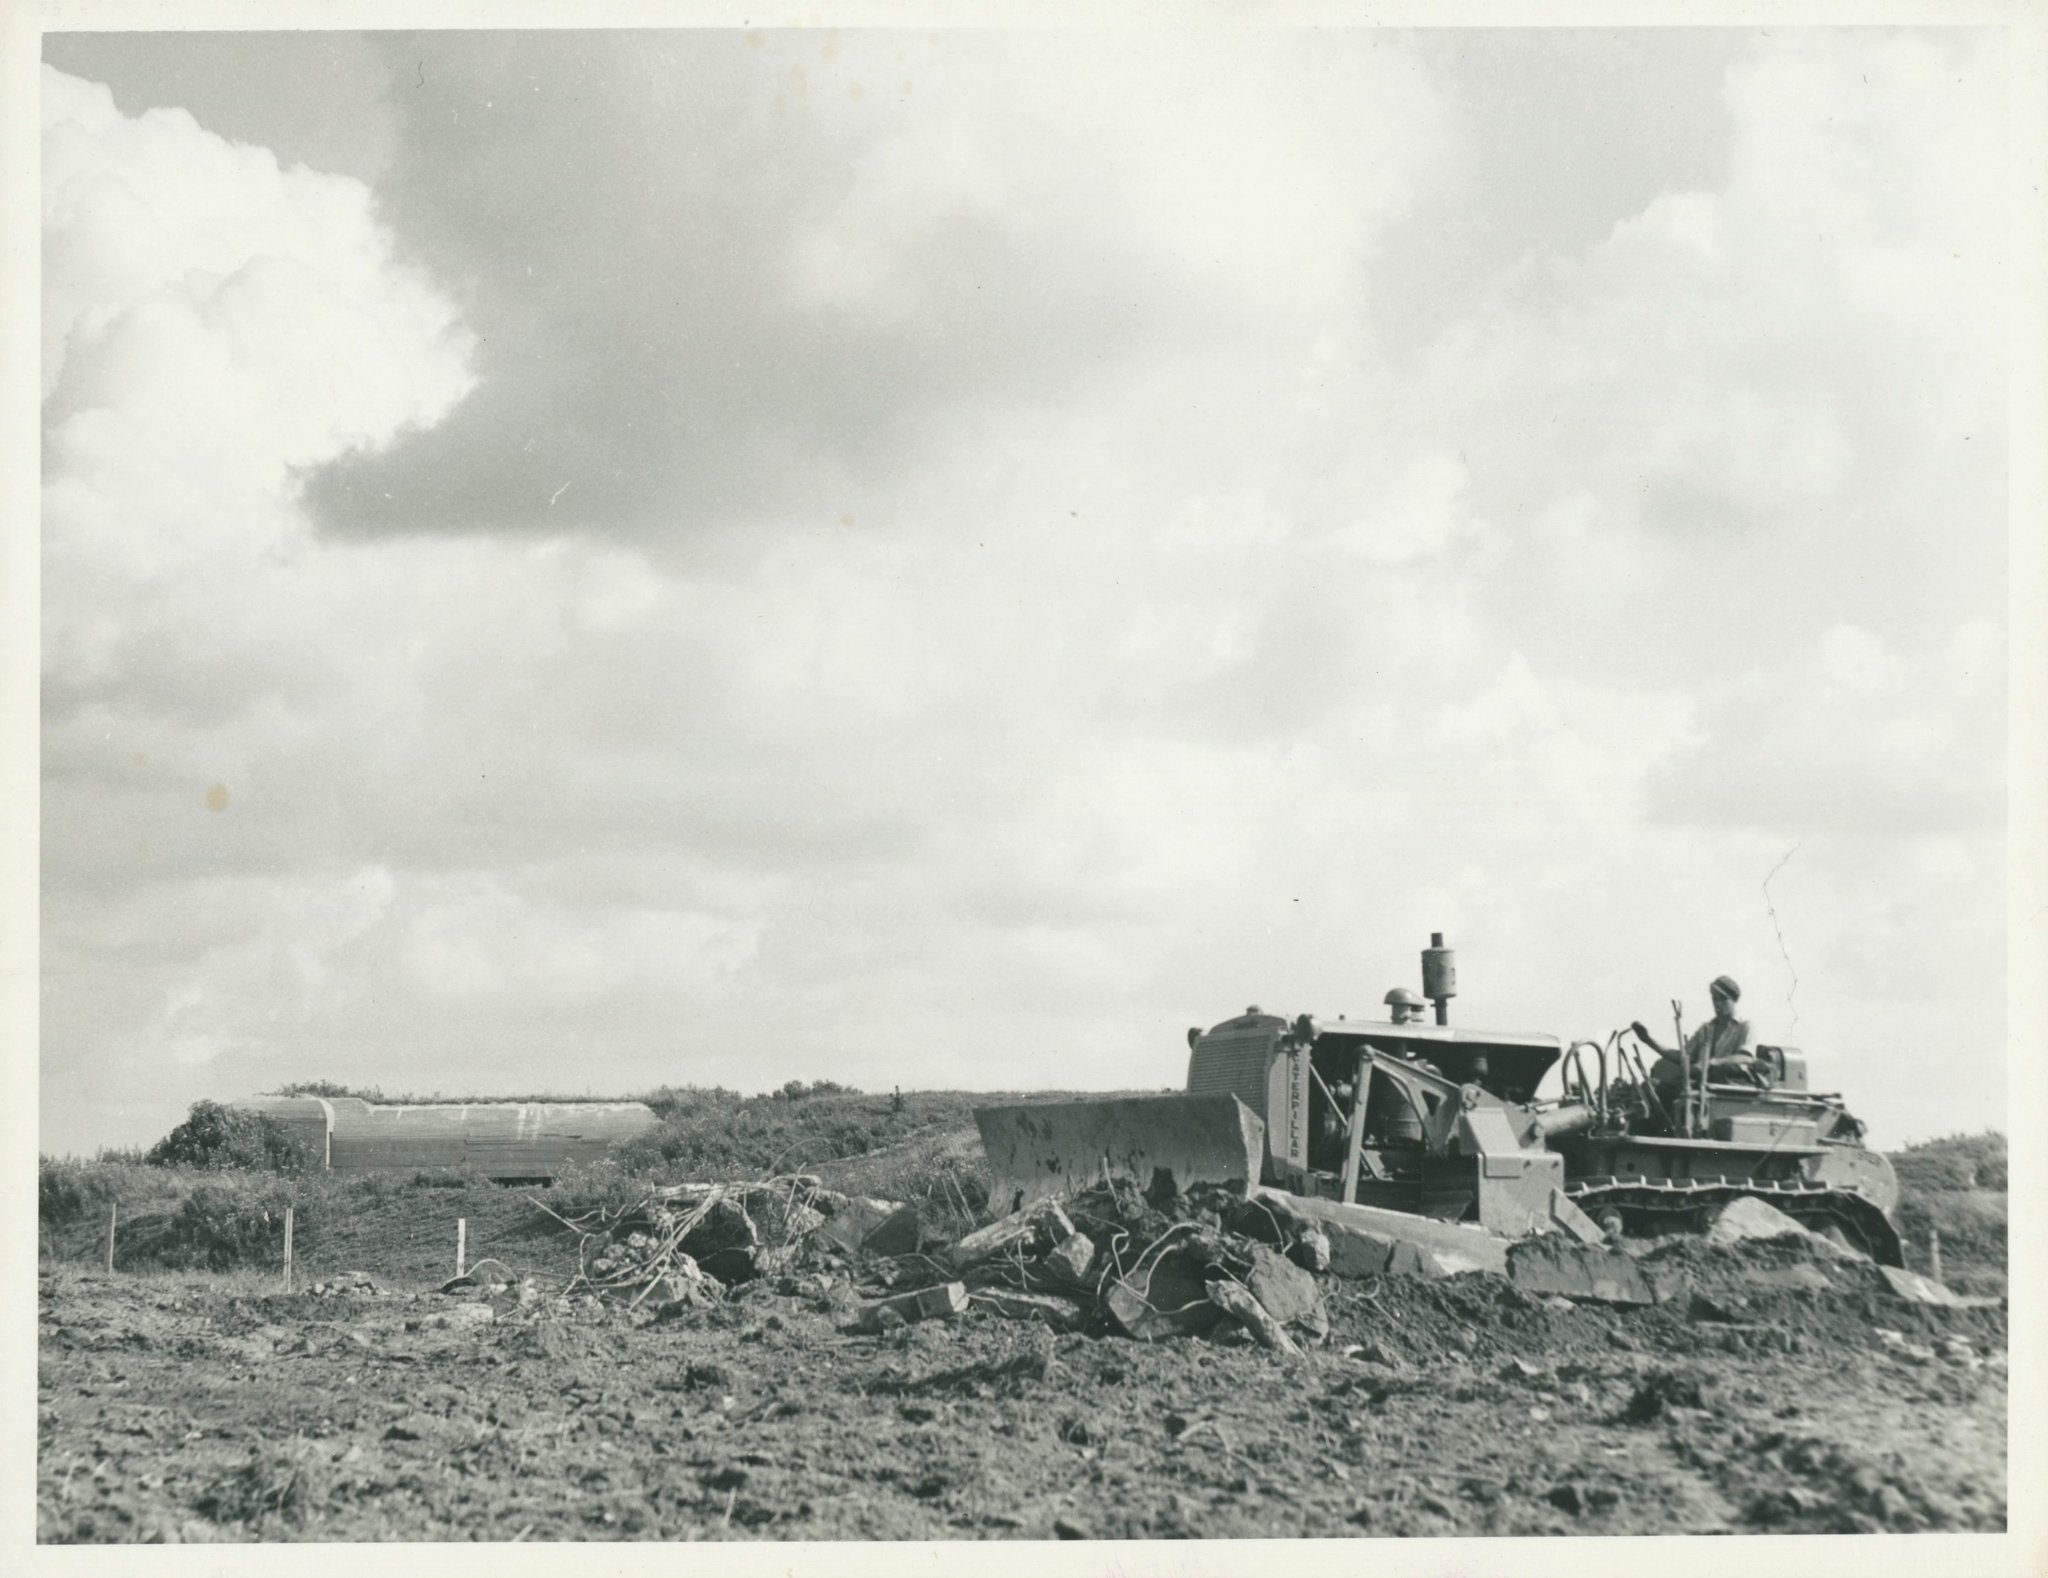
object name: documentary photograph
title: Hulp uit USA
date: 1946-1947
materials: photographic support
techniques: photography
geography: scheveningen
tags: scheveningen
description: Met bulldozers uit de USA worden de Duitse fortificaties langs de kust opgeruimd.